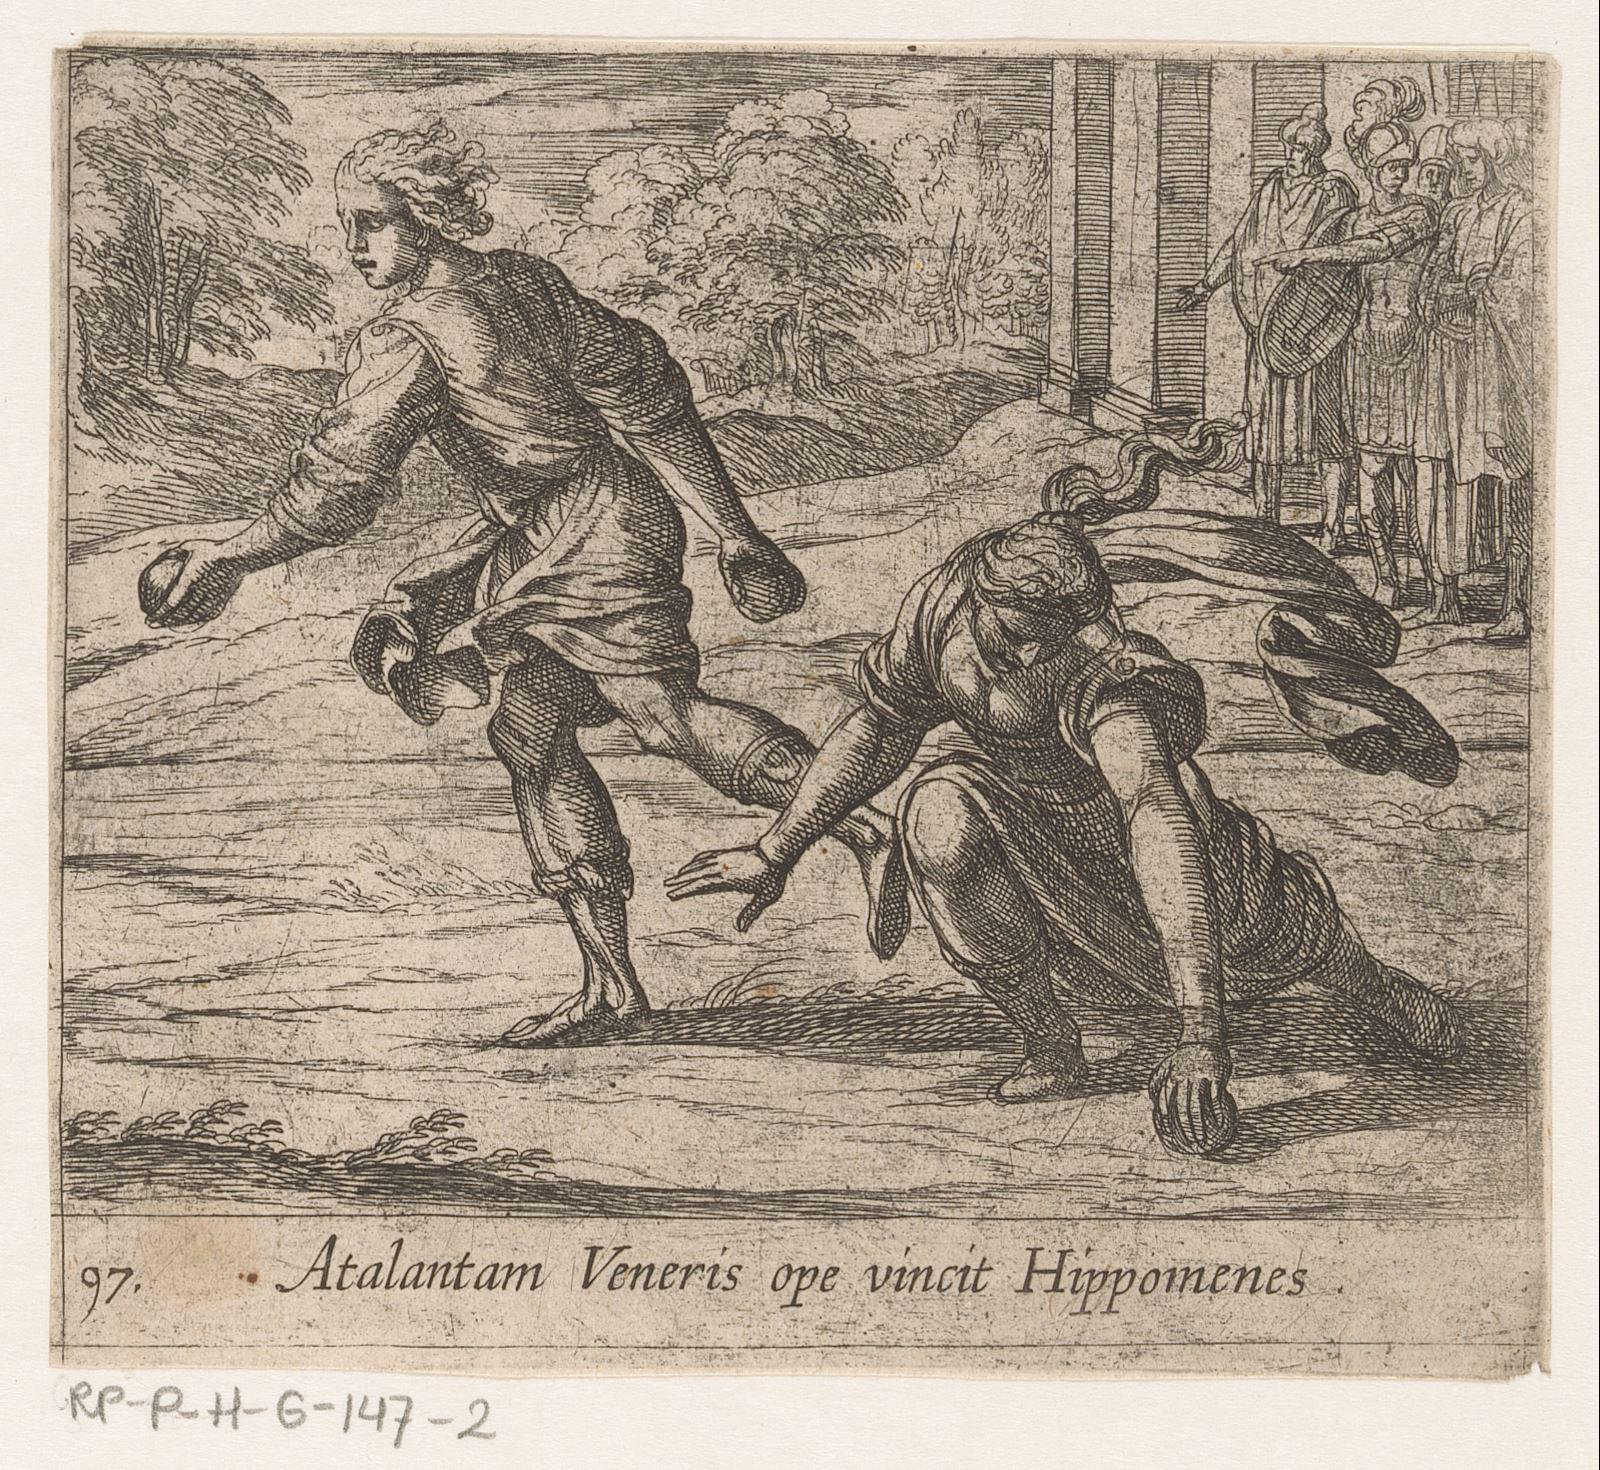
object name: print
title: Hippomenes wint de hardloopwedstrijd tegen Atalanta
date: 1606-1638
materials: paper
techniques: etching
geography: amsterdam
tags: during the foot-race hippomenes drops the three golden apples; atalante stops to pick them up, and is thus beaten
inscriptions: collector's mark: ‘Hinloopen’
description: Deze prent maakt deel uit van een reeks van 150 prenten (+ titelprent) met voorstellingen van de Metamorfosen van Ovidius.